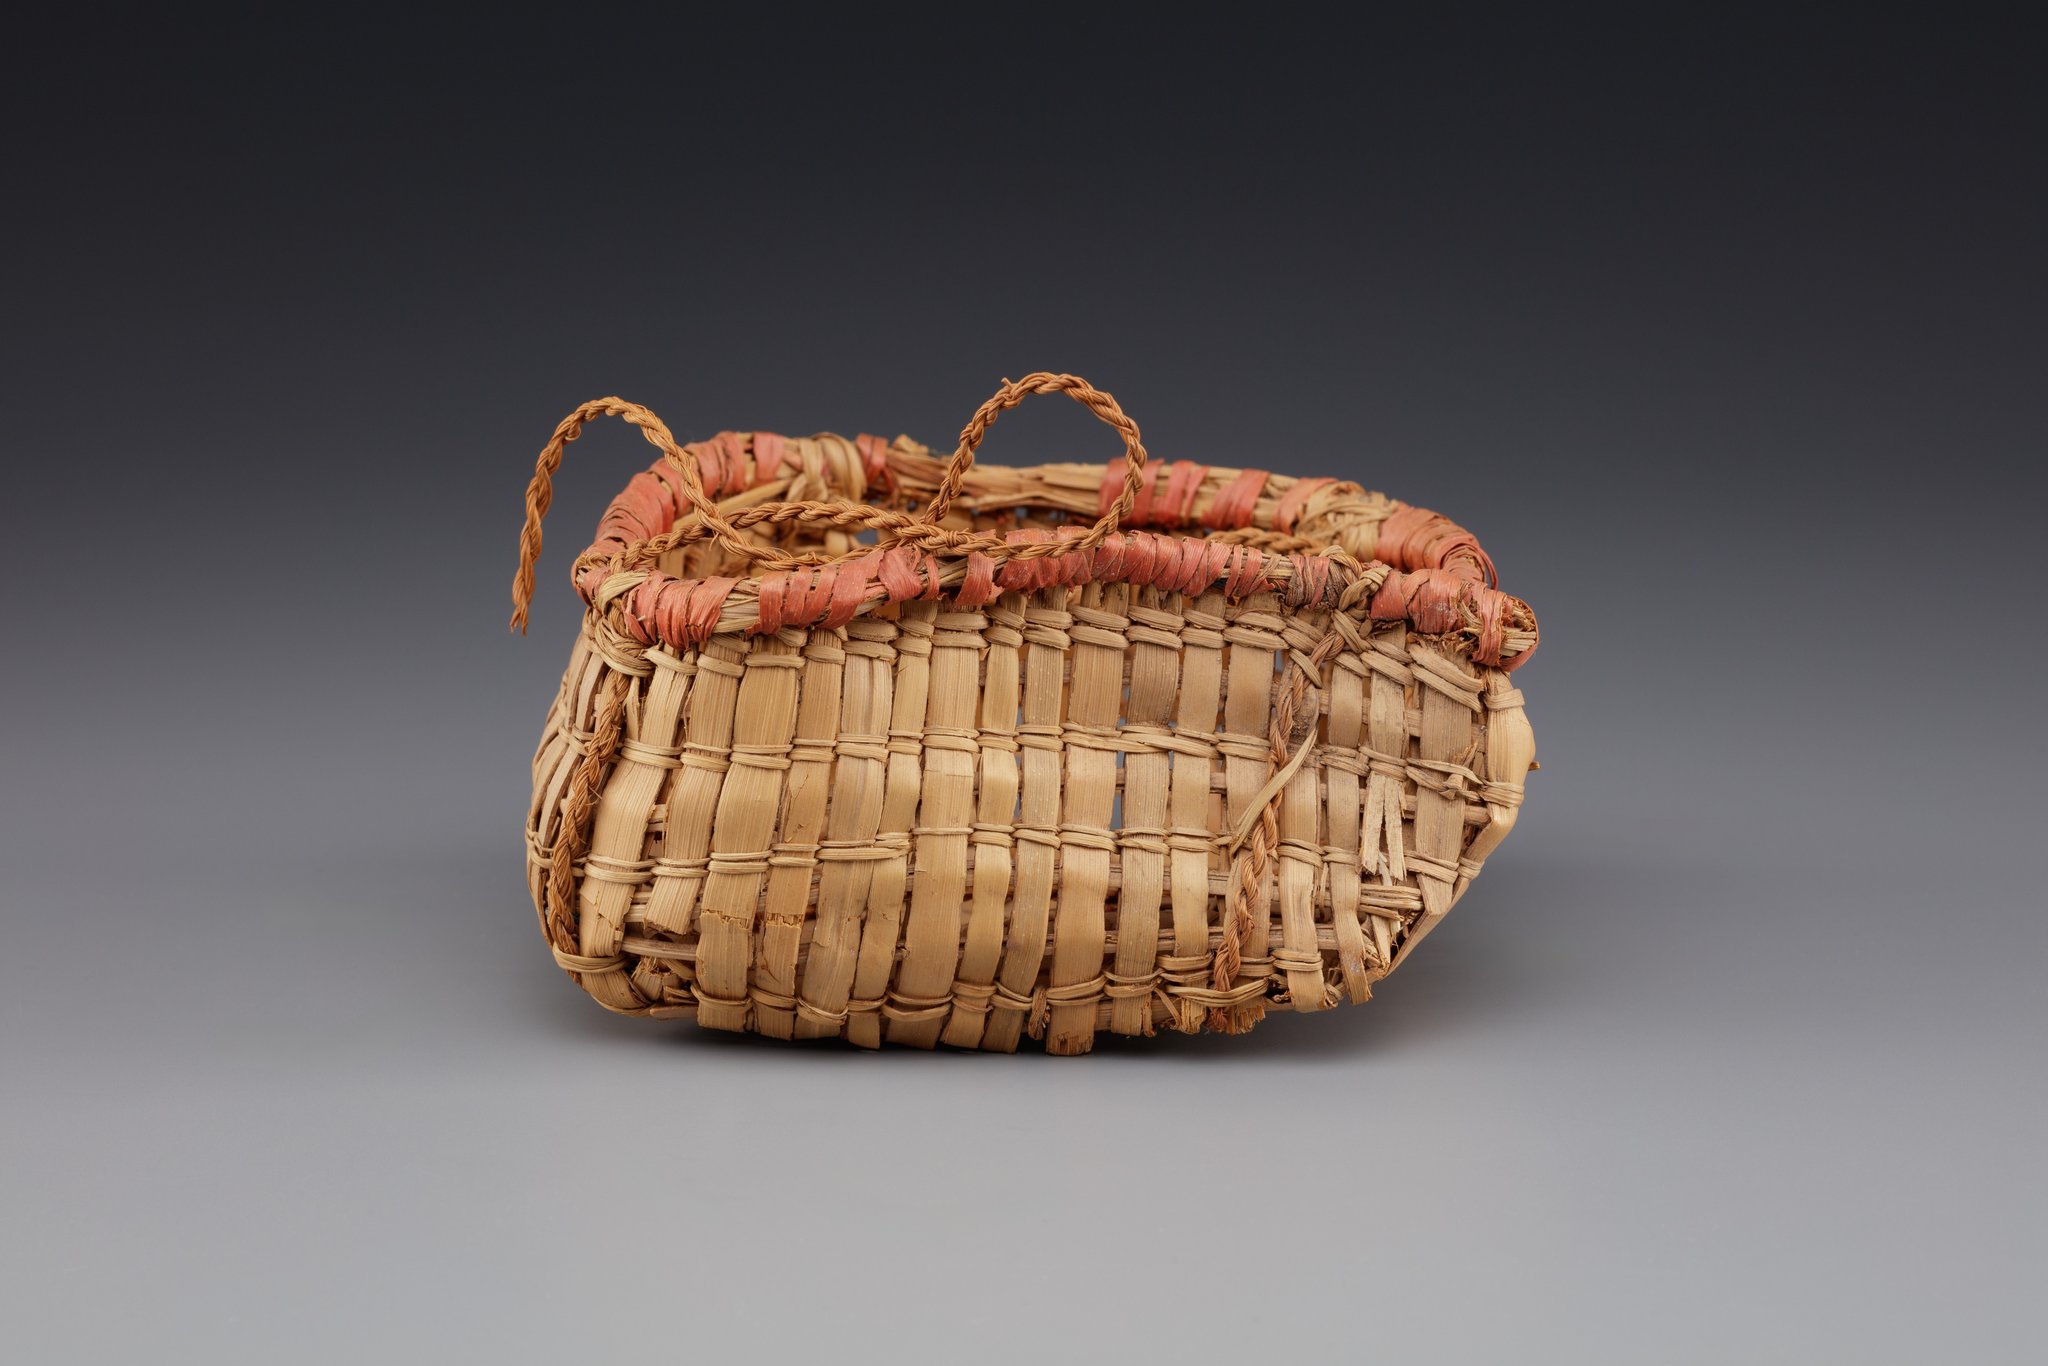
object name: basket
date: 1-100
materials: dye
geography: egypt